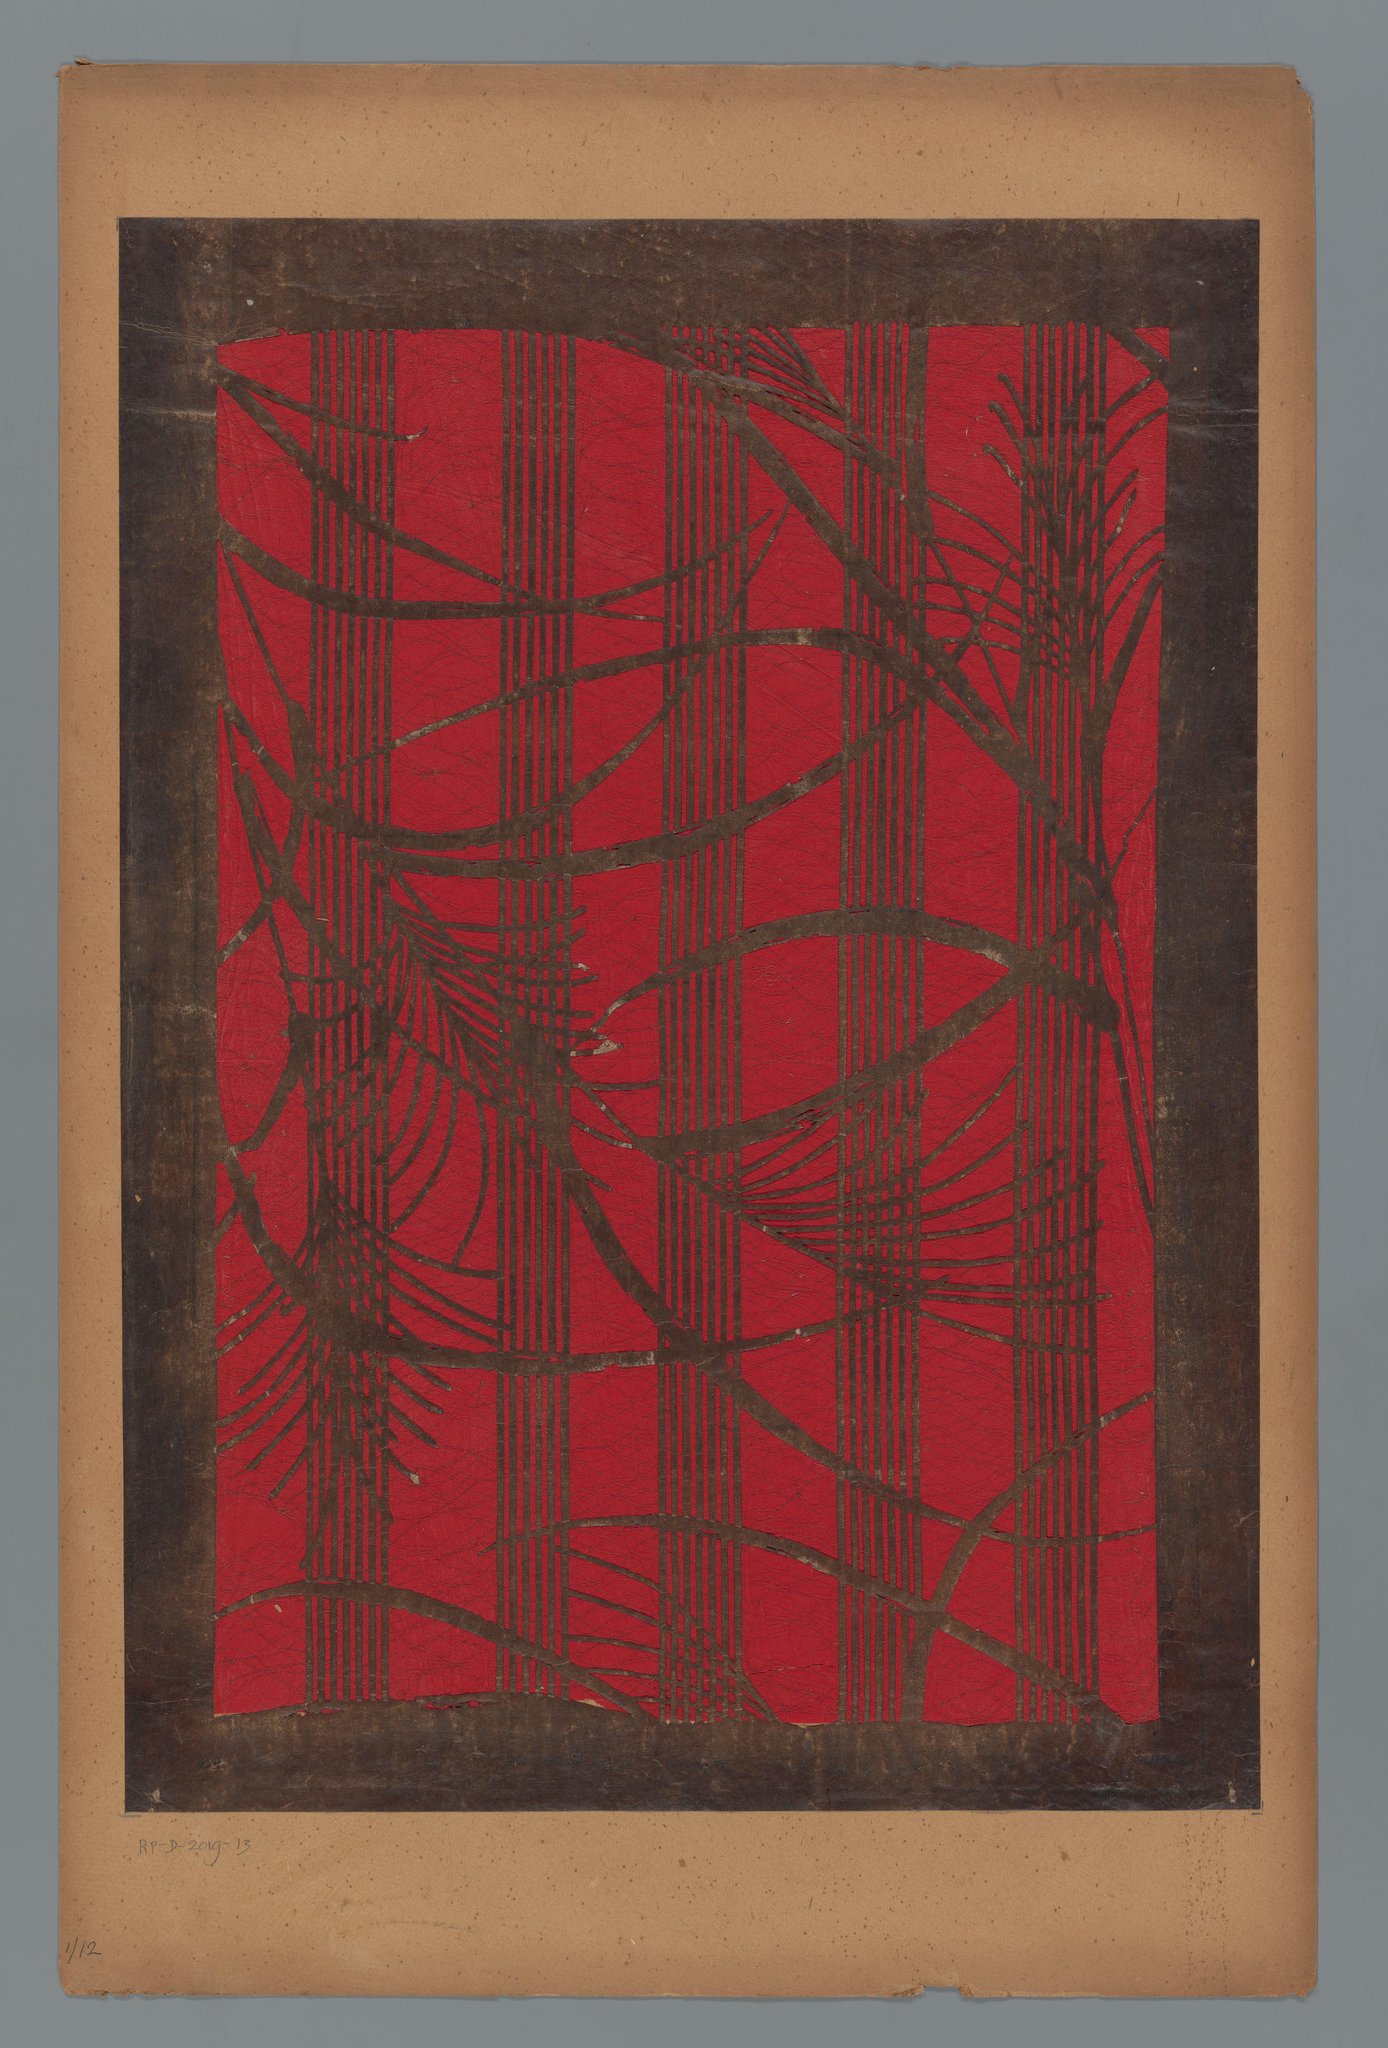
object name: katagami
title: Sjabloon met grashalmen en lijnen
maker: Anonymous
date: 1800-1909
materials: paper, silk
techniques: cutting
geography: japan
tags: ornament ~ geometric motifs, ornament derived from plant forms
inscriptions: stamp: ‘Afgeschreven W...’, number: ‘1/12’, stamp: ‘Museum van Kunstnijverheid Haarlem’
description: Japanse sjabloon (katagami) met een patroon van gras- of riethalmen met een fond van verticale banen met lijnen.